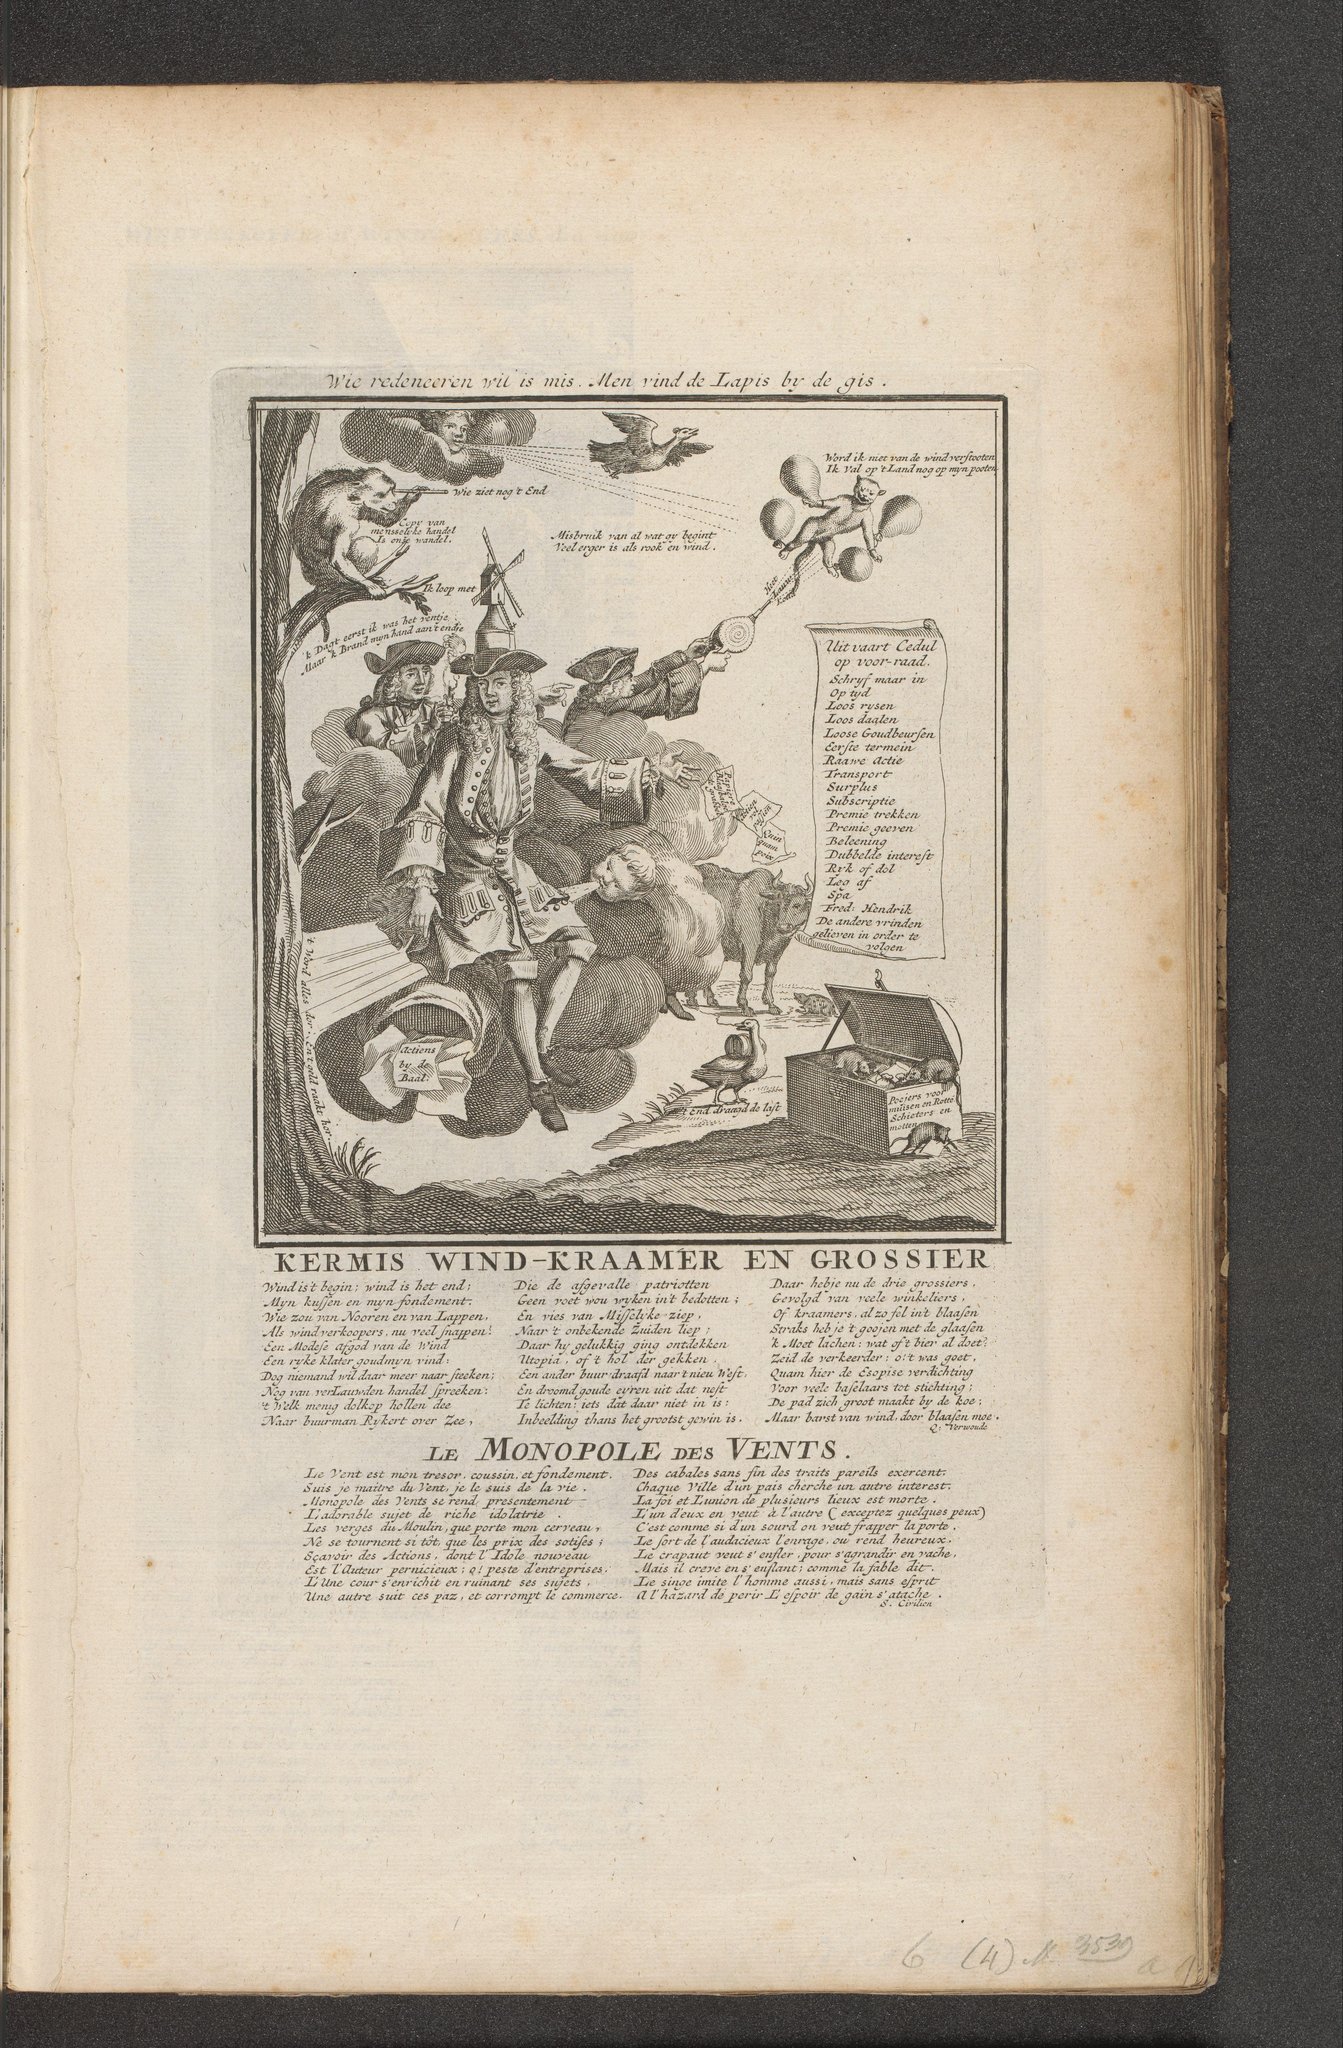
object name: cartoon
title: Een windhandelaar zit op een zak met aandelen die alleen door de wind hoog wordt gehouden, 1720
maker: Anonymous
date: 1720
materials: paper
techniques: etching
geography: northern netherlands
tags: windhandel van 1720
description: Een windhandelaar met een windmolen op zijn hoofd zit op een zak met aandelen die alleen door de wind hoog wordt gehouden, 1720. Links in de boom een aap met een verrekijker, rechts vliegt een kat met ballonnen aan zijn poten door de lucht. In het onderschrift verzen in het Nederlands en Frans. Prent in de gebonden vierde uitgave (304 B 12) van Het Groote Tafereel der Dwaasheid met spotprenten op de Windhandel of Actiehandel van 1720.